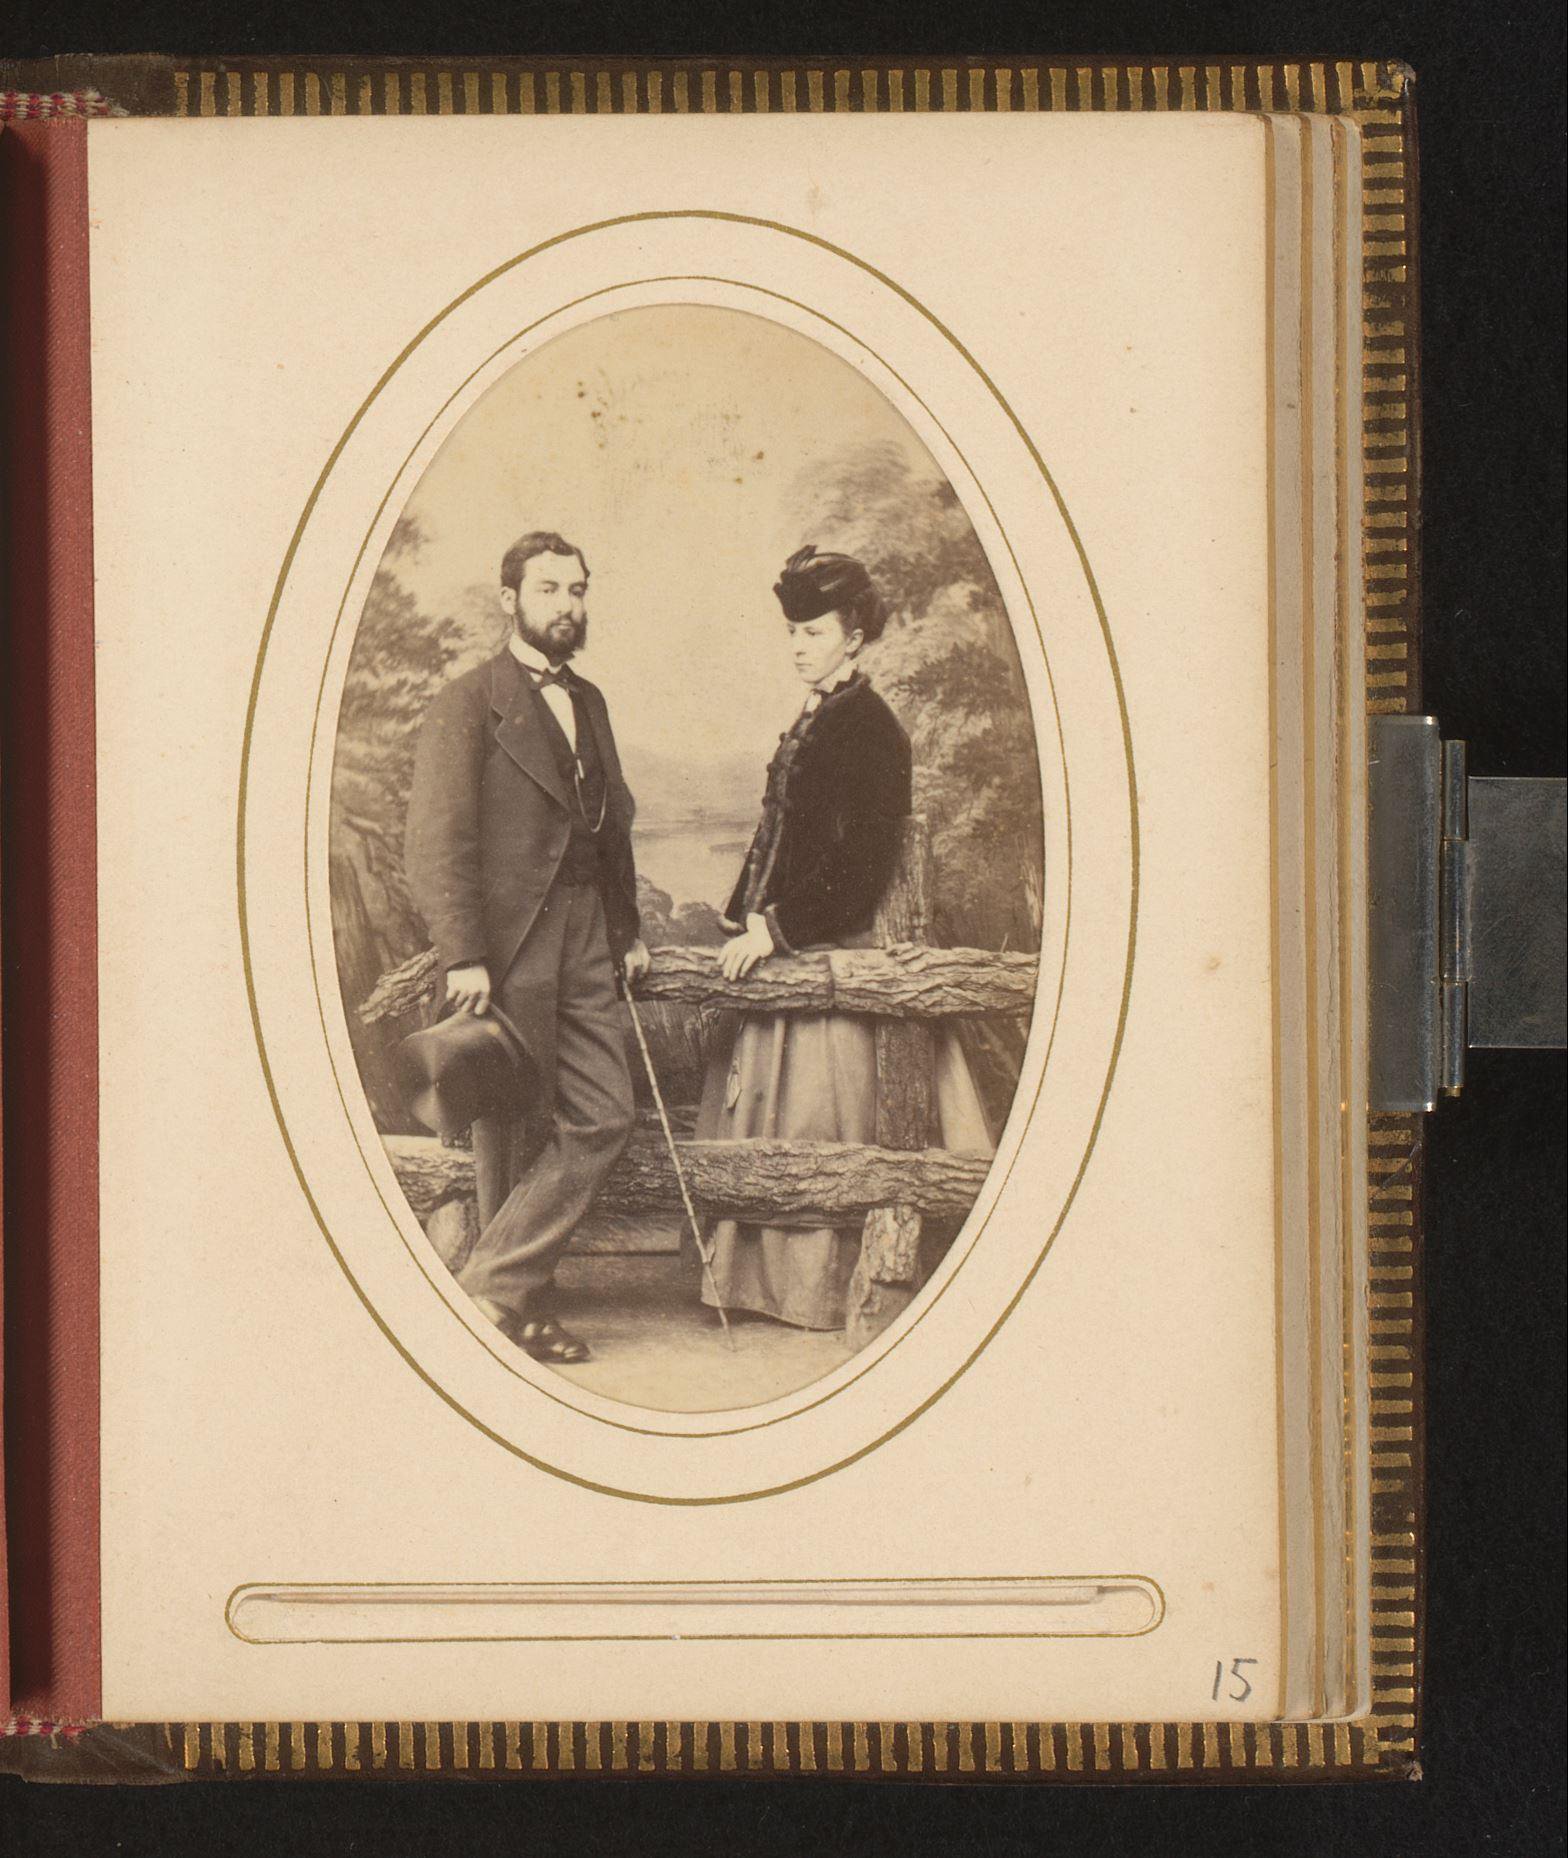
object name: album leaf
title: Portret van een man en een vrouw, staande bij een hek van boomstammen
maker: Anonymous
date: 1860-1885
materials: cardboard, paper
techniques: albumen print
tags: historical persons - bb - woman, walking-stick, staff, adult man, historical persons, head-gear: top hat